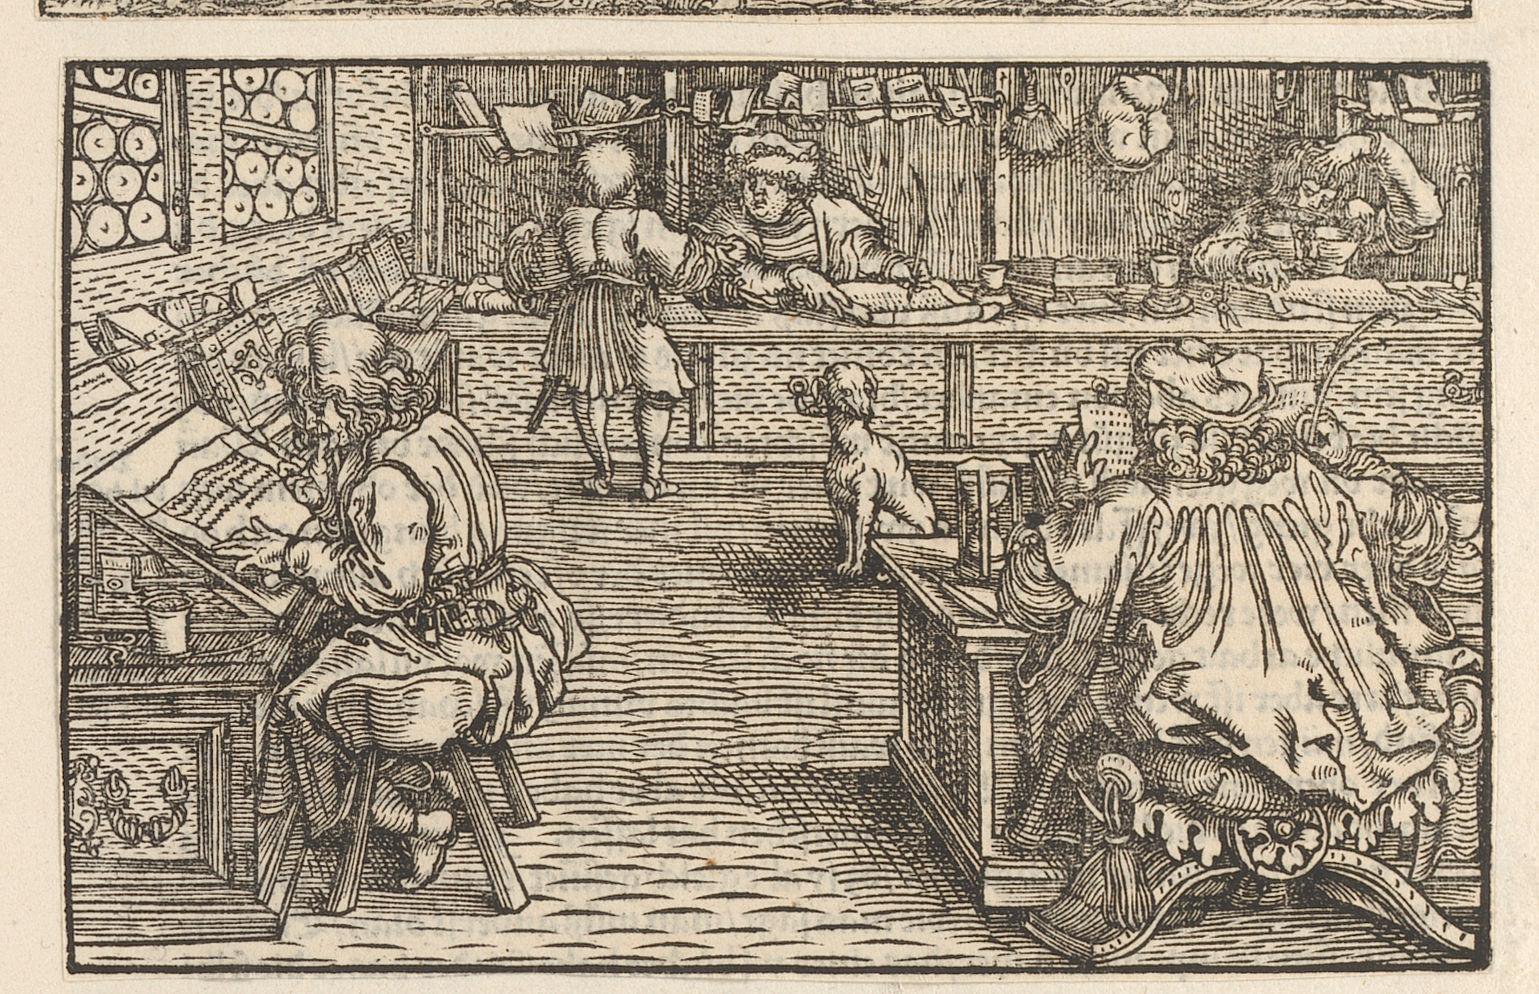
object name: book illustration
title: Mannen lezen in een bibliotheek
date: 1514-1532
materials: paper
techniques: letterpress printing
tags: study; 'studiolo'; library, public library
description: Deze prent is gebruikt in: Petrarca, Francesco. Von der Artzney bayder Glück, des guten und widerwertigen: unnd weß sich ain yeder inn Gelück und Unglück halten sol (...). Augsburg: Heinrich Steiner, 1532. Deze uitgave is ook bekend onder de titel 'Trostspiegel in Glück und Unglück'. Deze prent is ook gebruikt in: Cicero, Marcus Tulius. Officia M.T.C. Ein Buch so Marcus Tullius Cicero der Römer zu seynem (...). [Vertaald uit het Latijn door] Johann von Schwarzenberg. Augsburg: Heinrich Steiner, 1531.